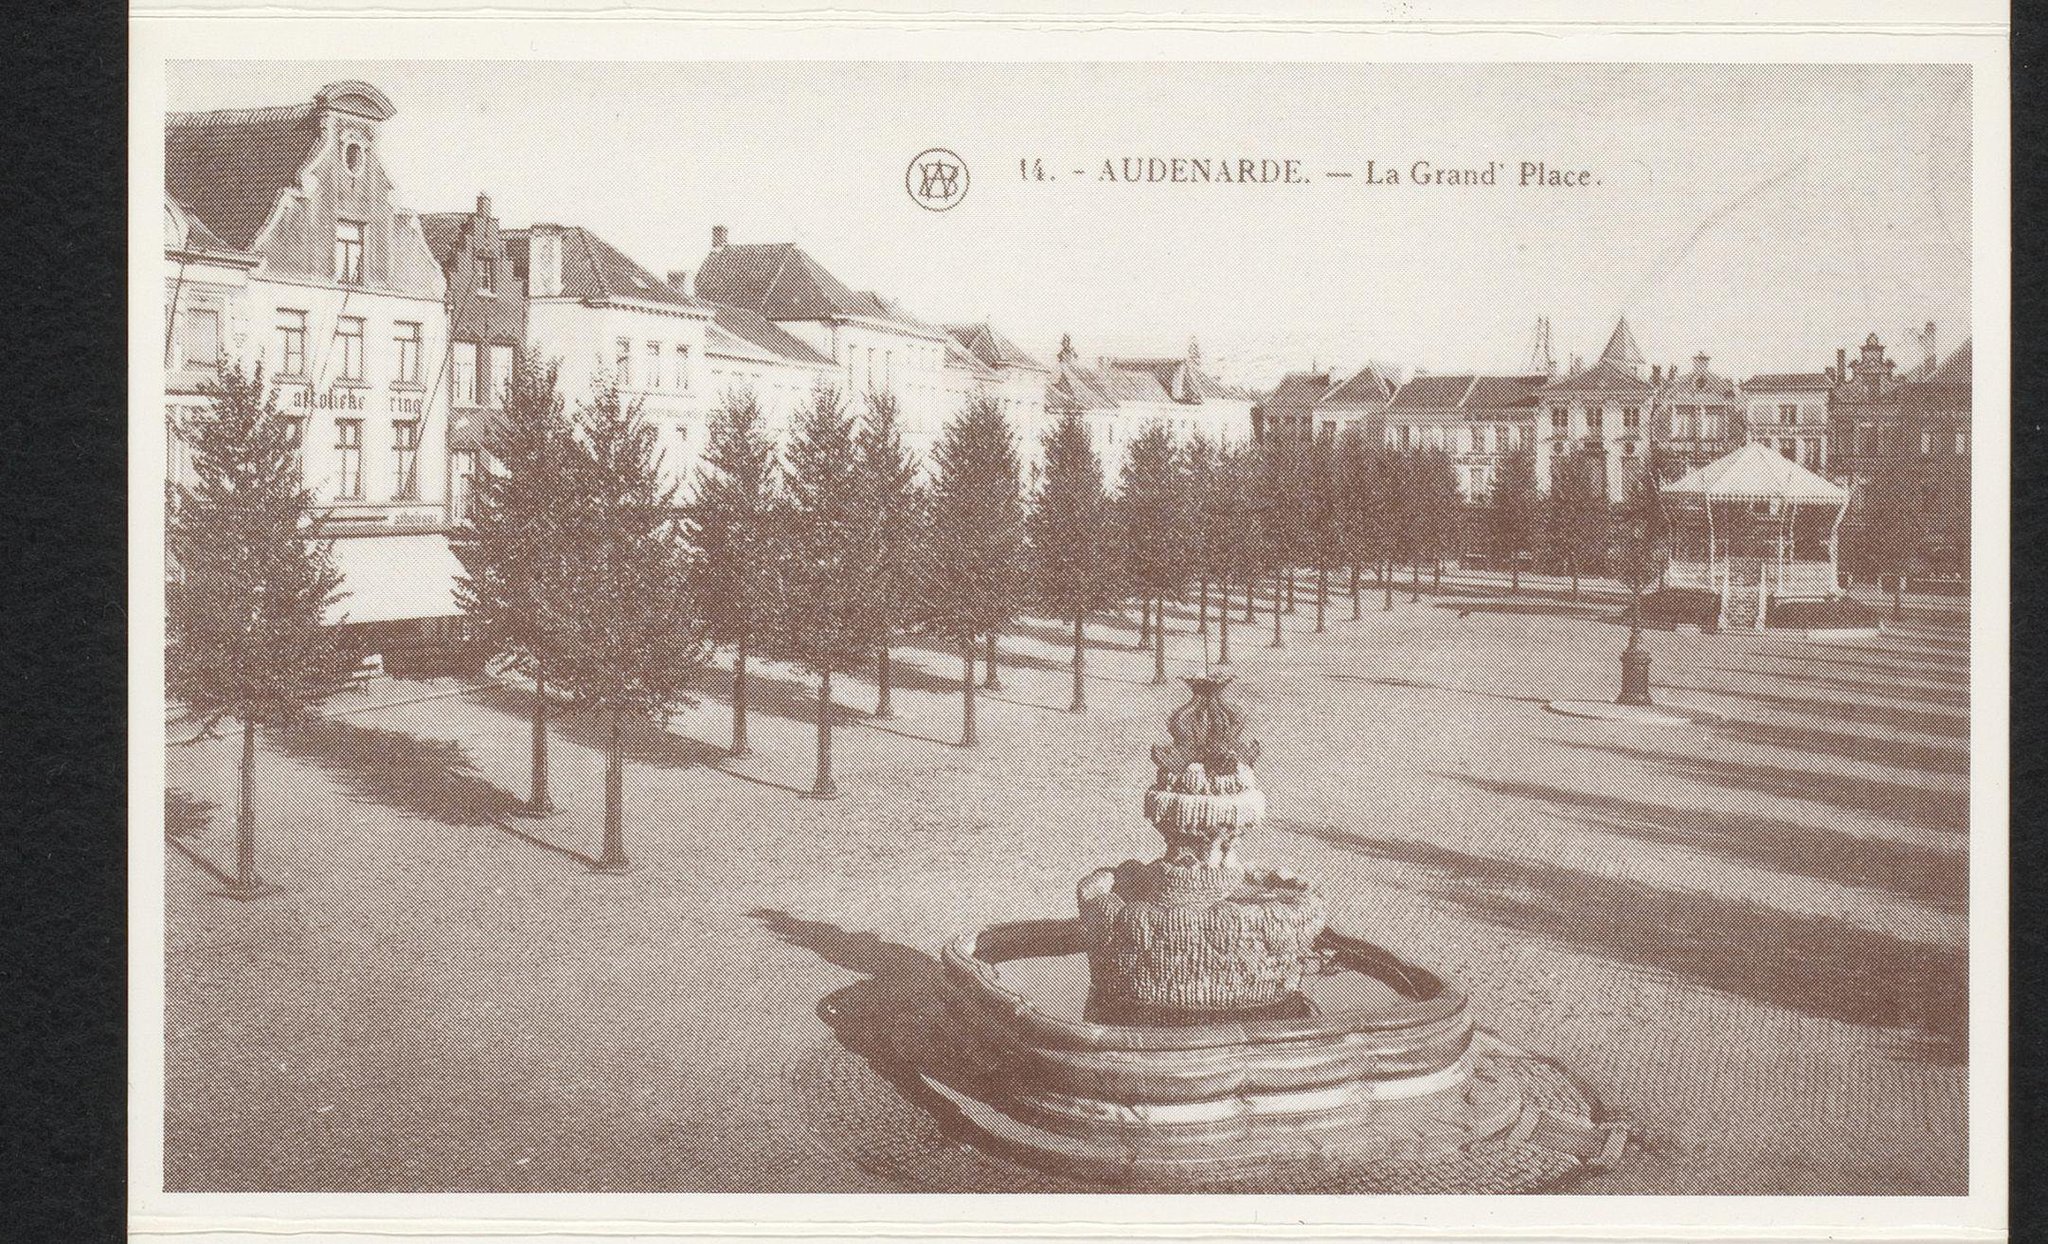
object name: photomechanical print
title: Audenarde. La Grand'Place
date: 1981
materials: cardboard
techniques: offset printed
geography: brussels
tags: square, place, circus, etc., bandstand, ornamental fountain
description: Deze prentbriefkaart is een reproductie van een oudere prentbriefkaart.